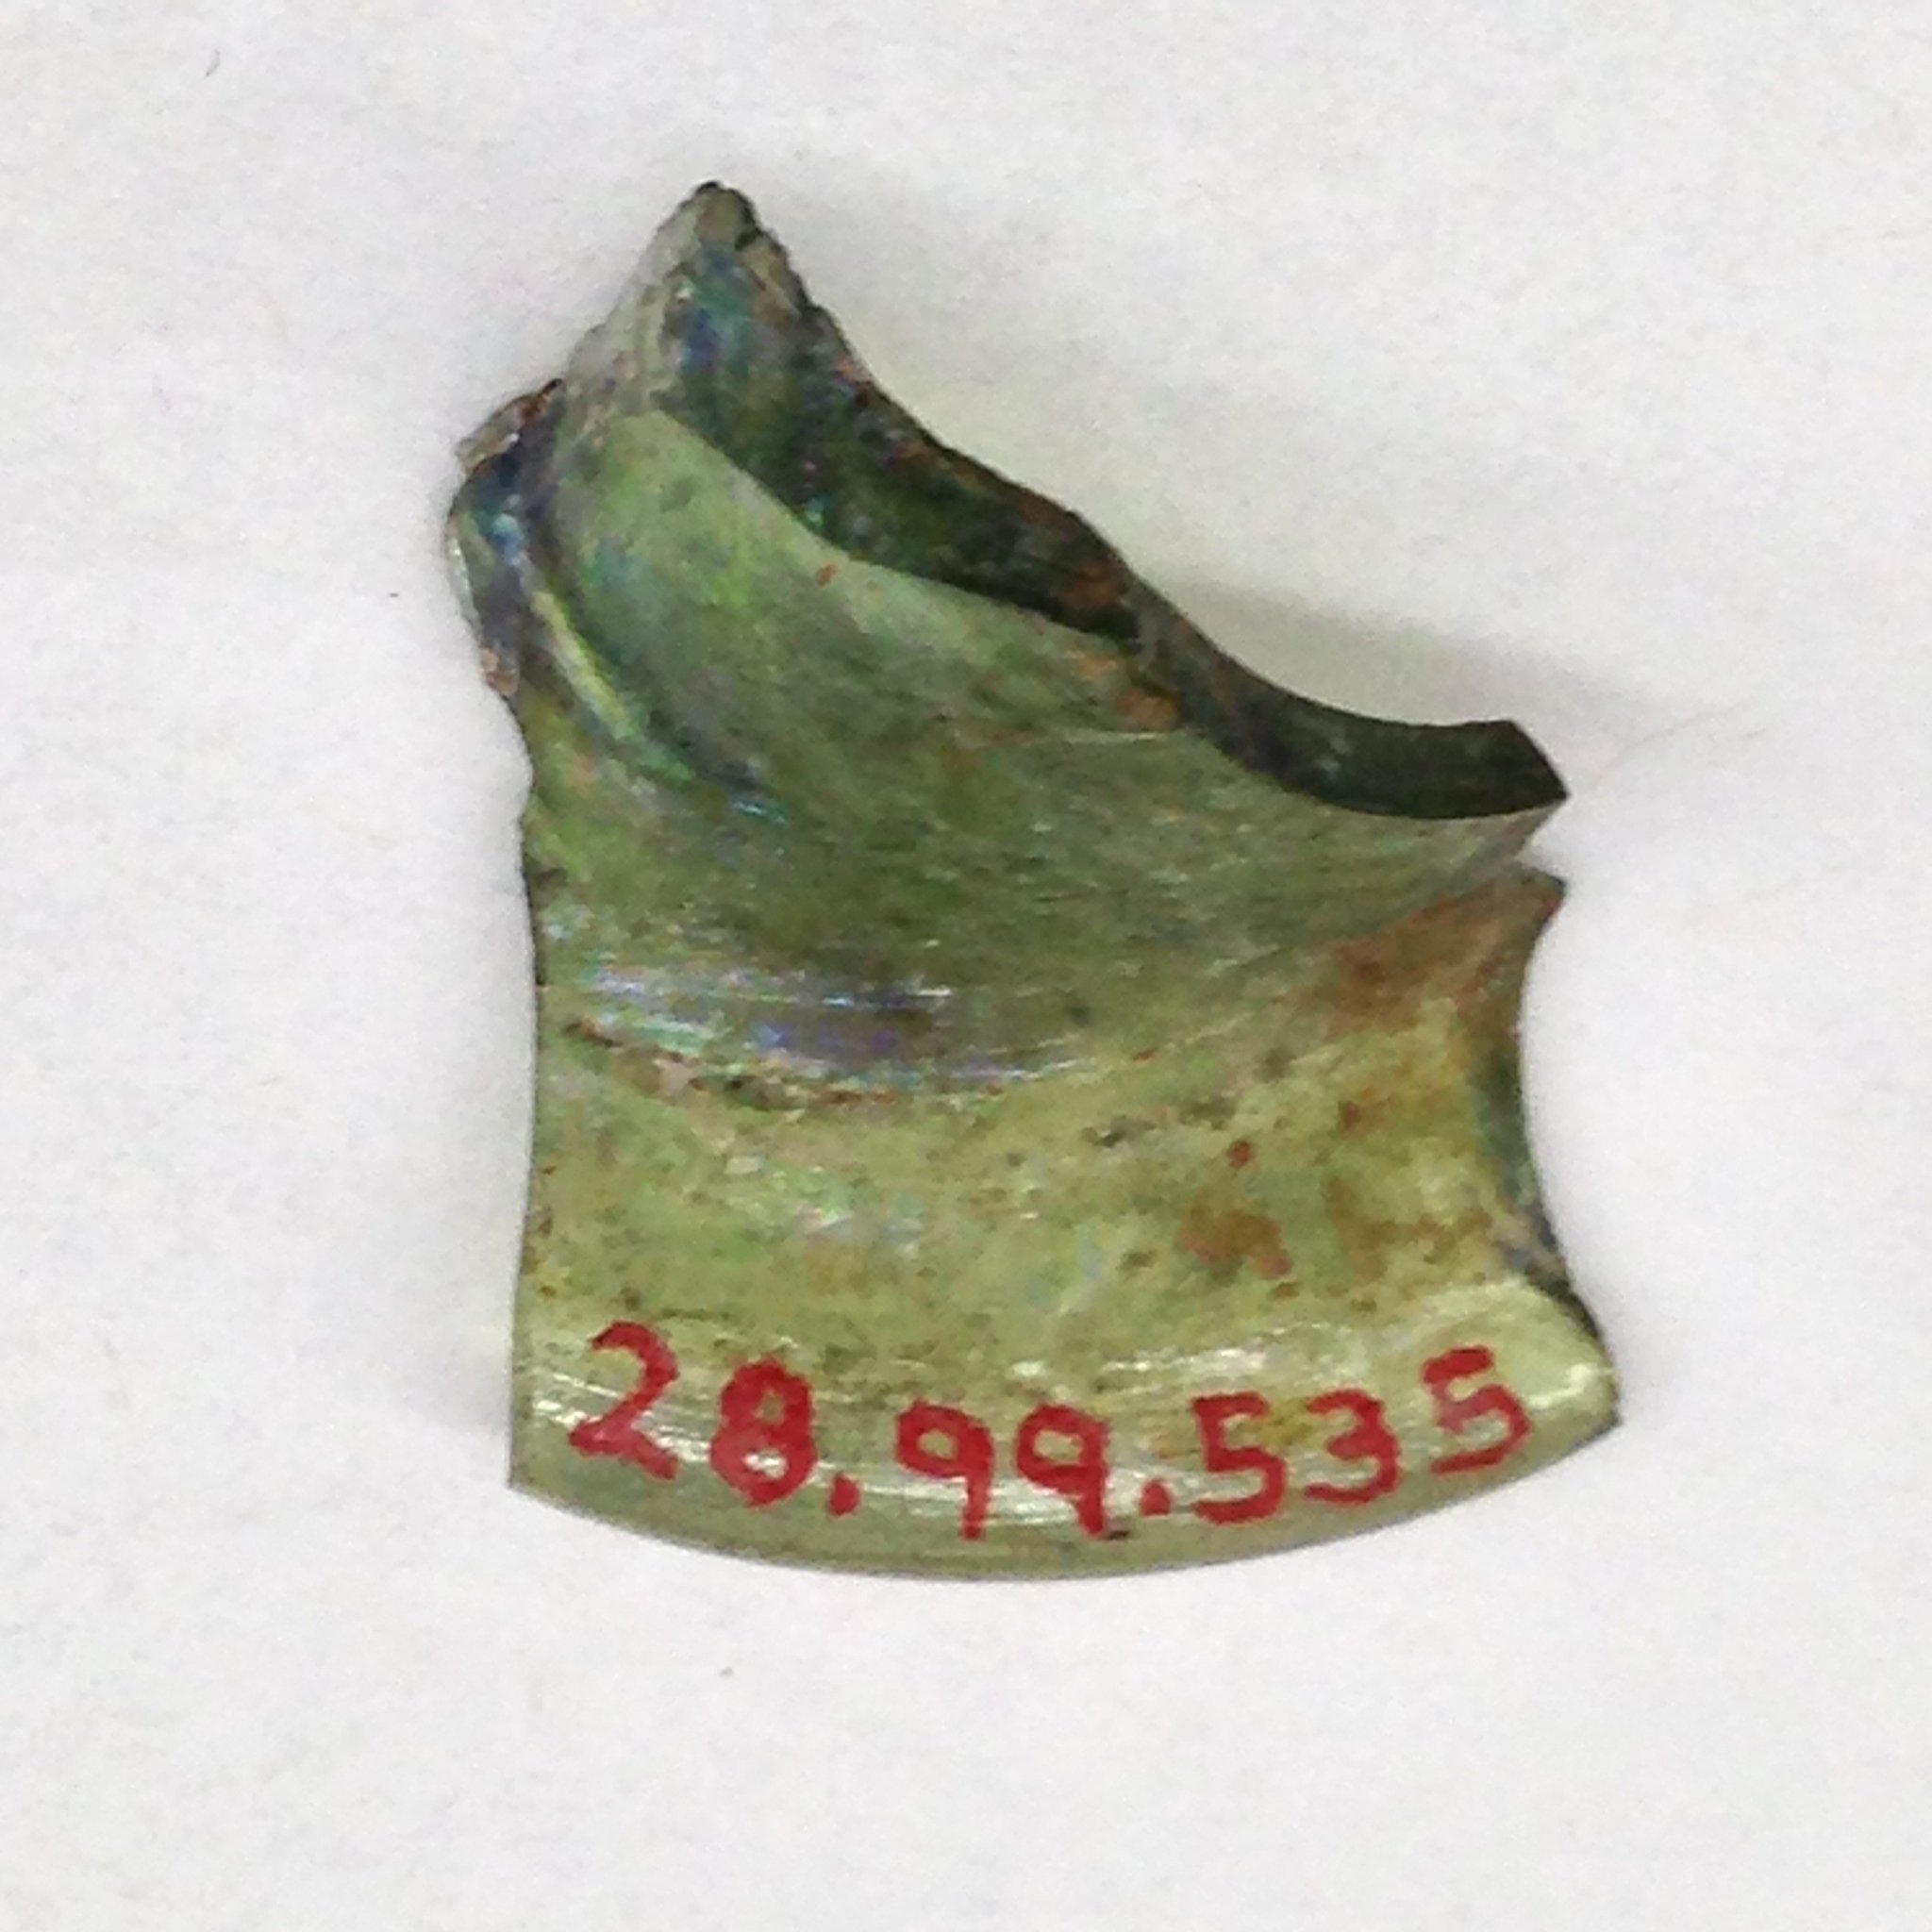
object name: fragment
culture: european or middle eastern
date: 1150-1250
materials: ceramic, glass